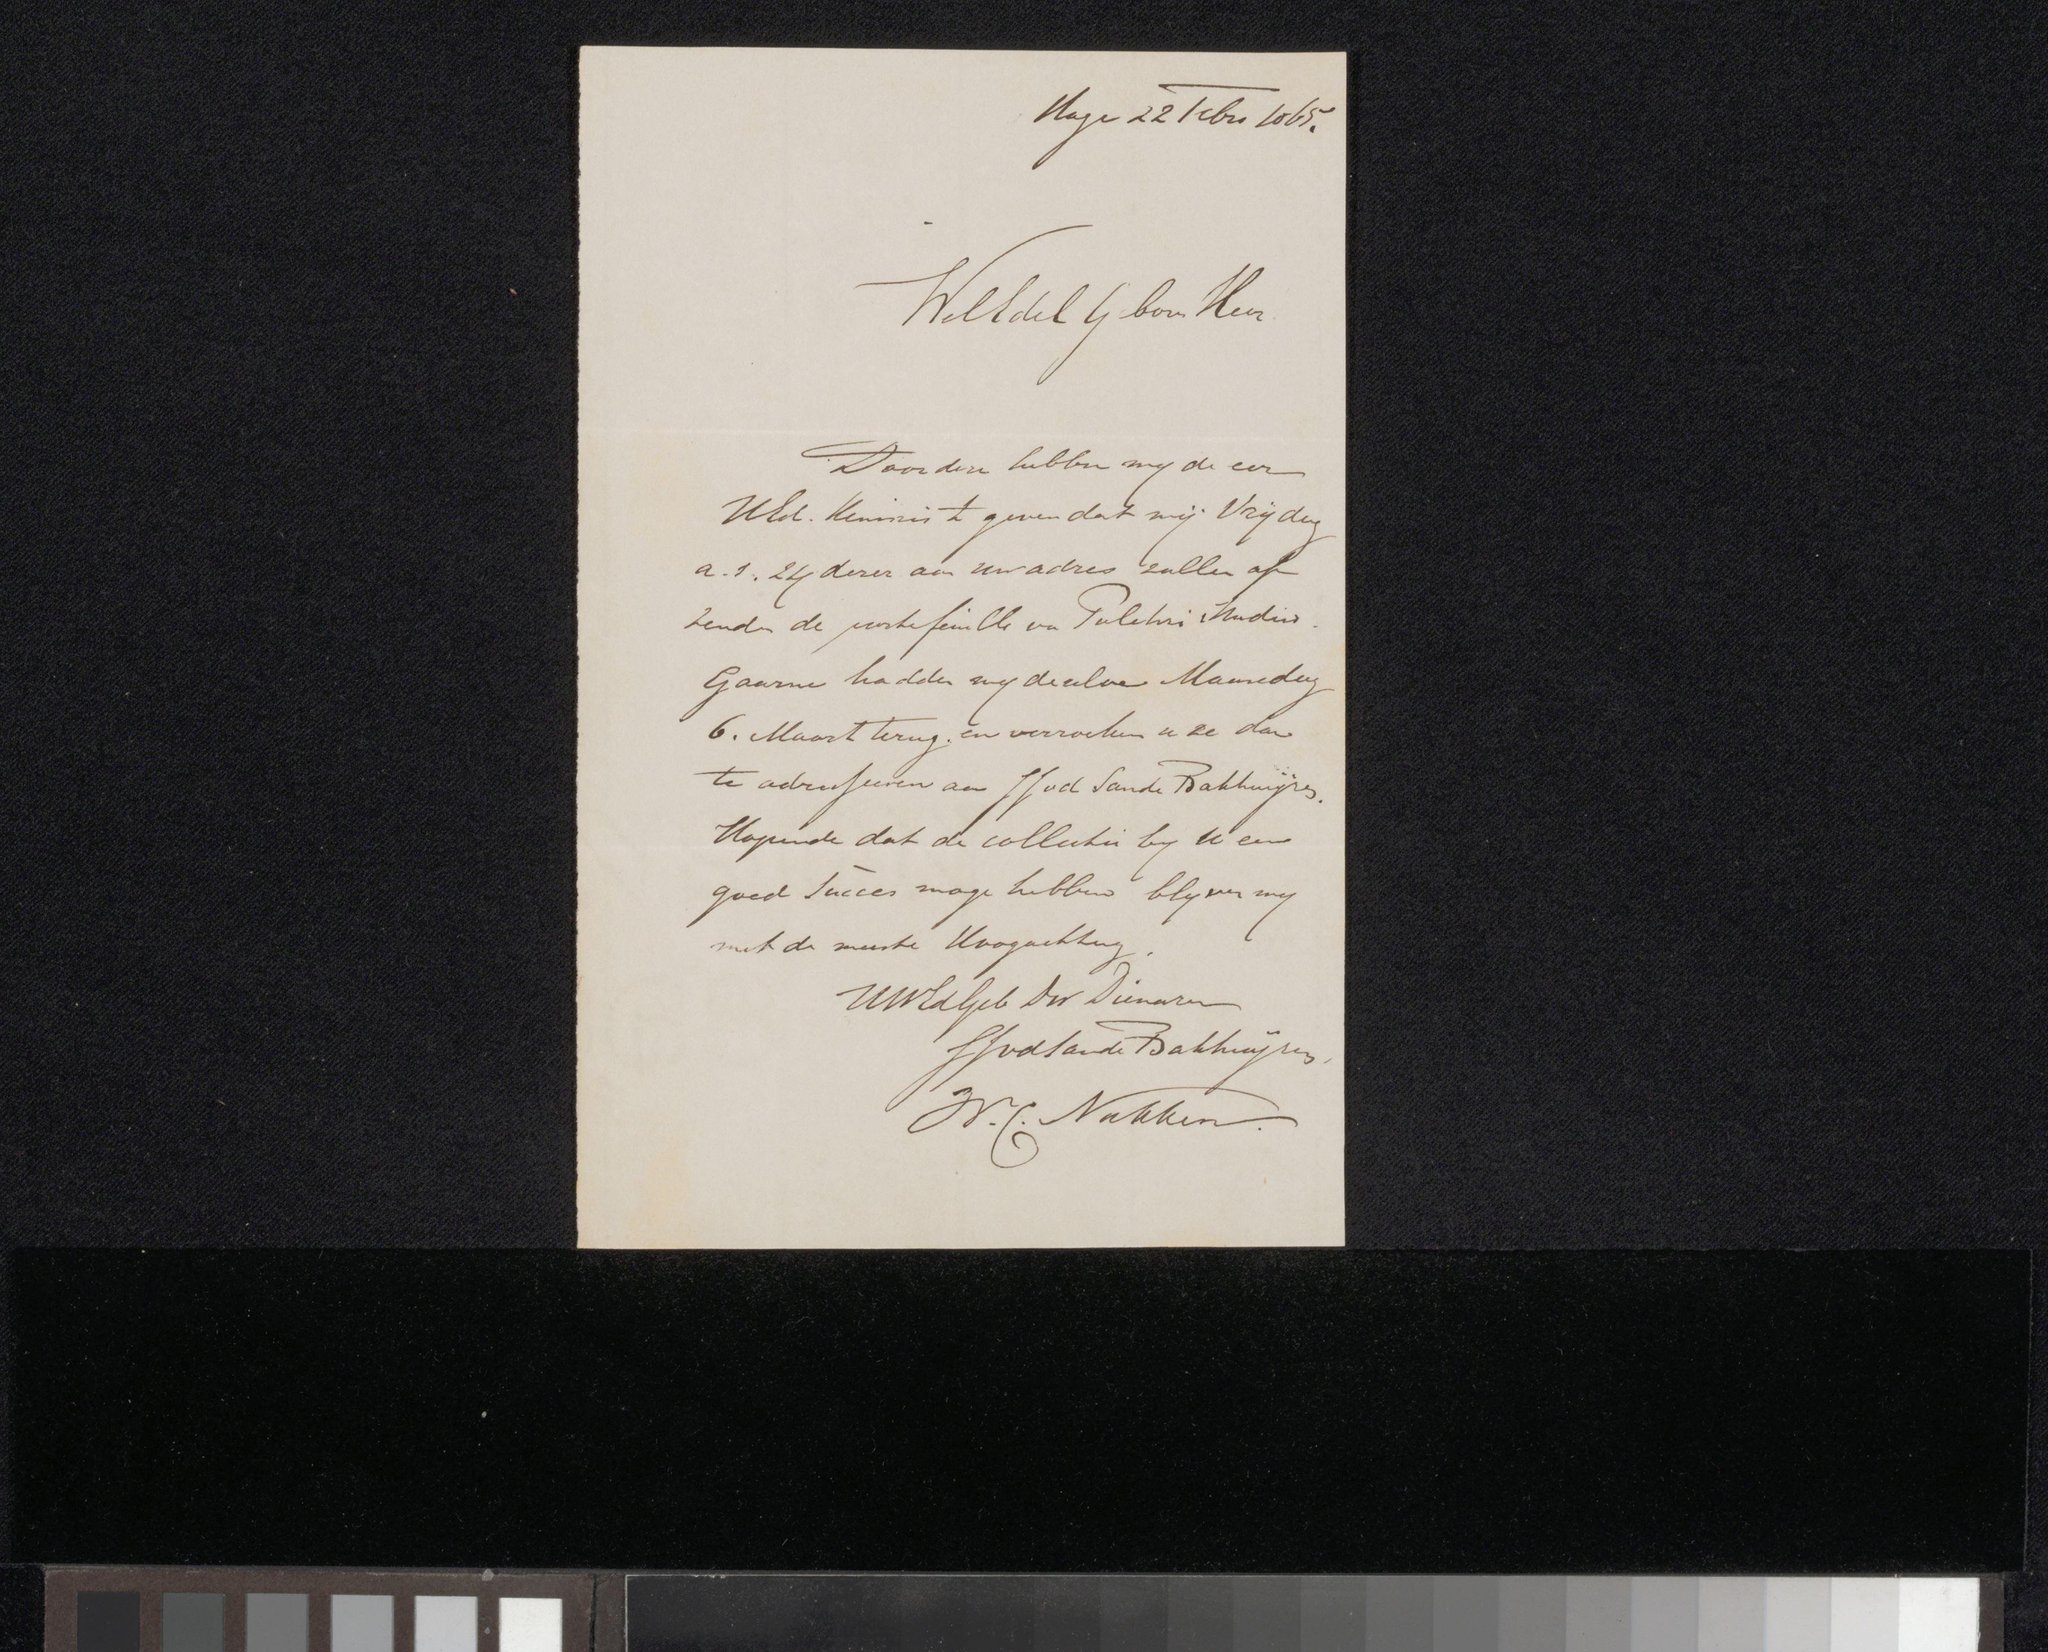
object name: letter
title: Brief aan anoniem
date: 1865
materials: ink, paper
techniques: pen, writing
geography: the hague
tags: pulchri studio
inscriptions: watermark